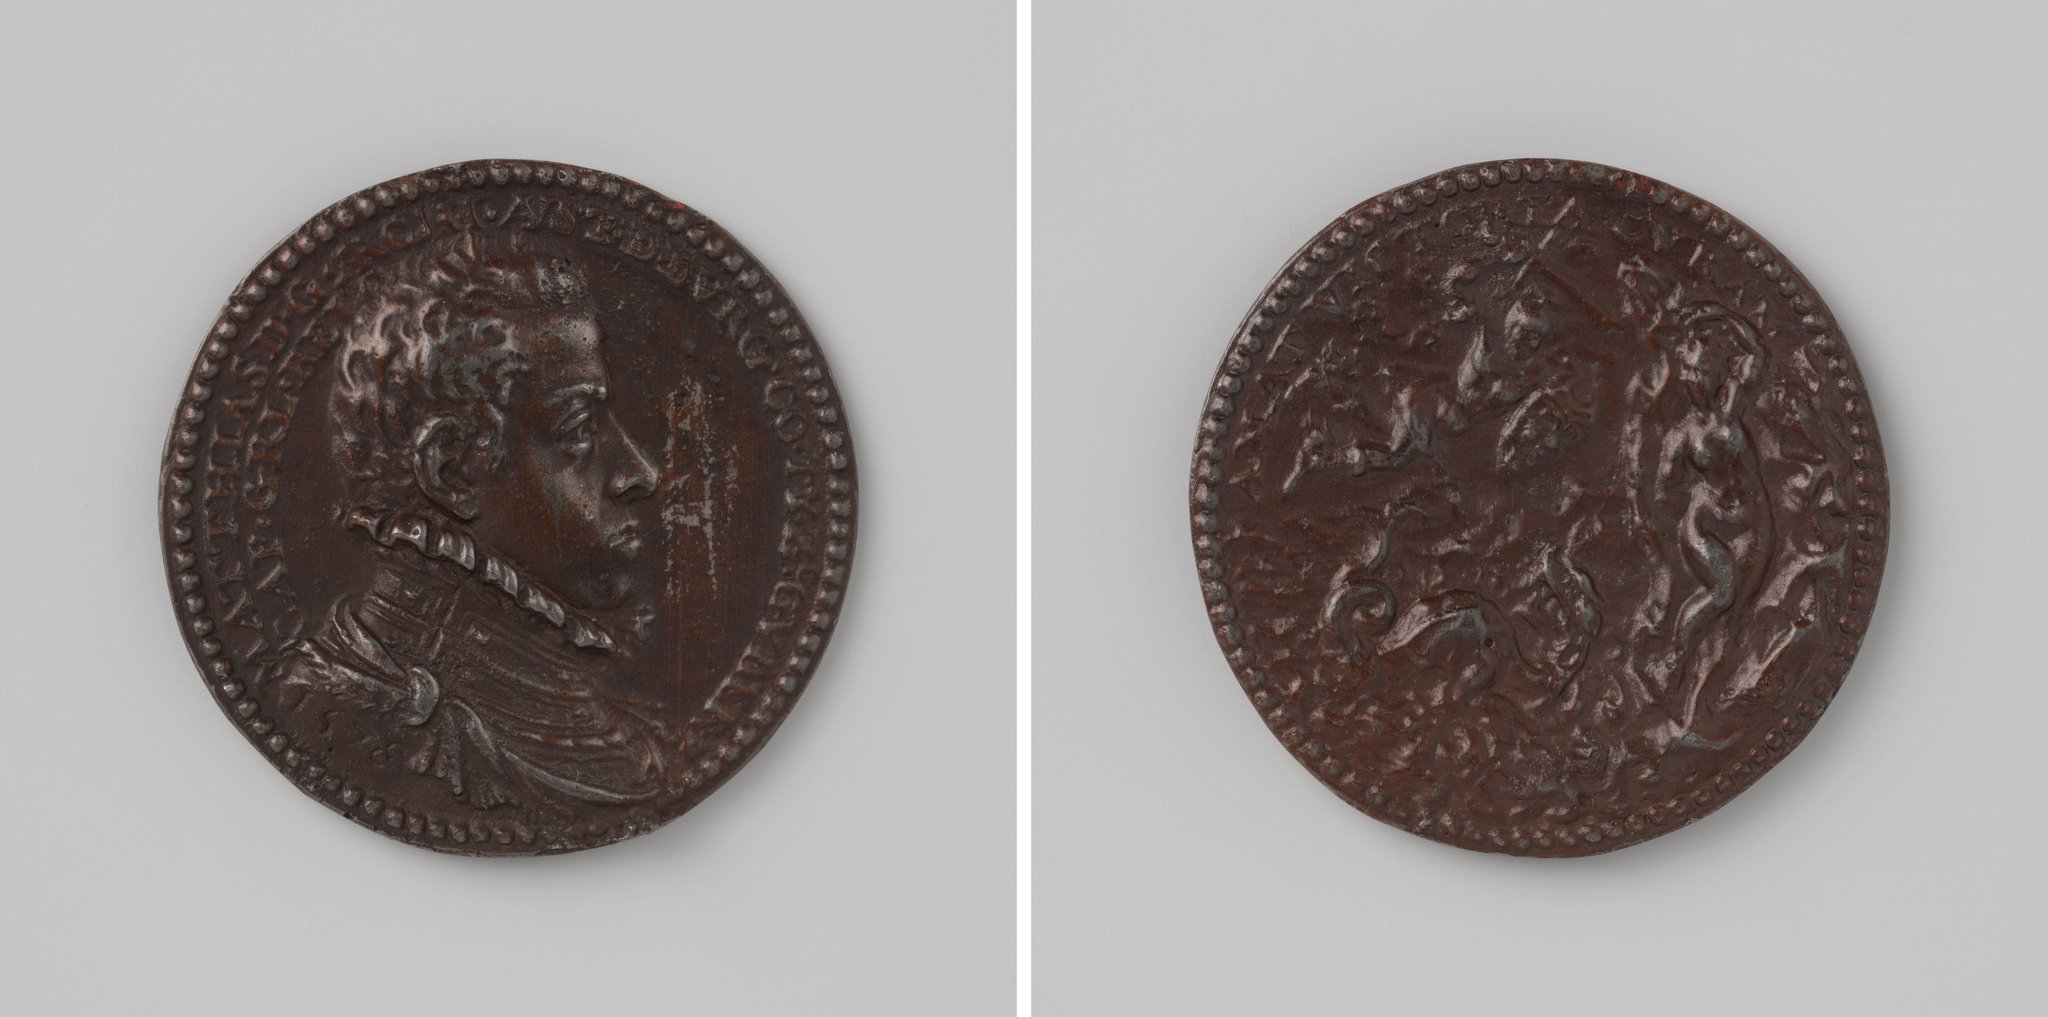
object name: history medal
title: Inhuldiging in Brussel van Matthias van Oostenrijk als landvoogd van de Nederlanden 1578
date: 1578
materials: tin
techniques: casting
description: Bruin gelakt tinnen penning, op de voorzijde het borstbeeld van Matthias naar rechts met omschrift, op de keerzijde de Nederlanden als Andromeda die van het zeemonster worden gered door Matthias als Perseus, met omschrift.